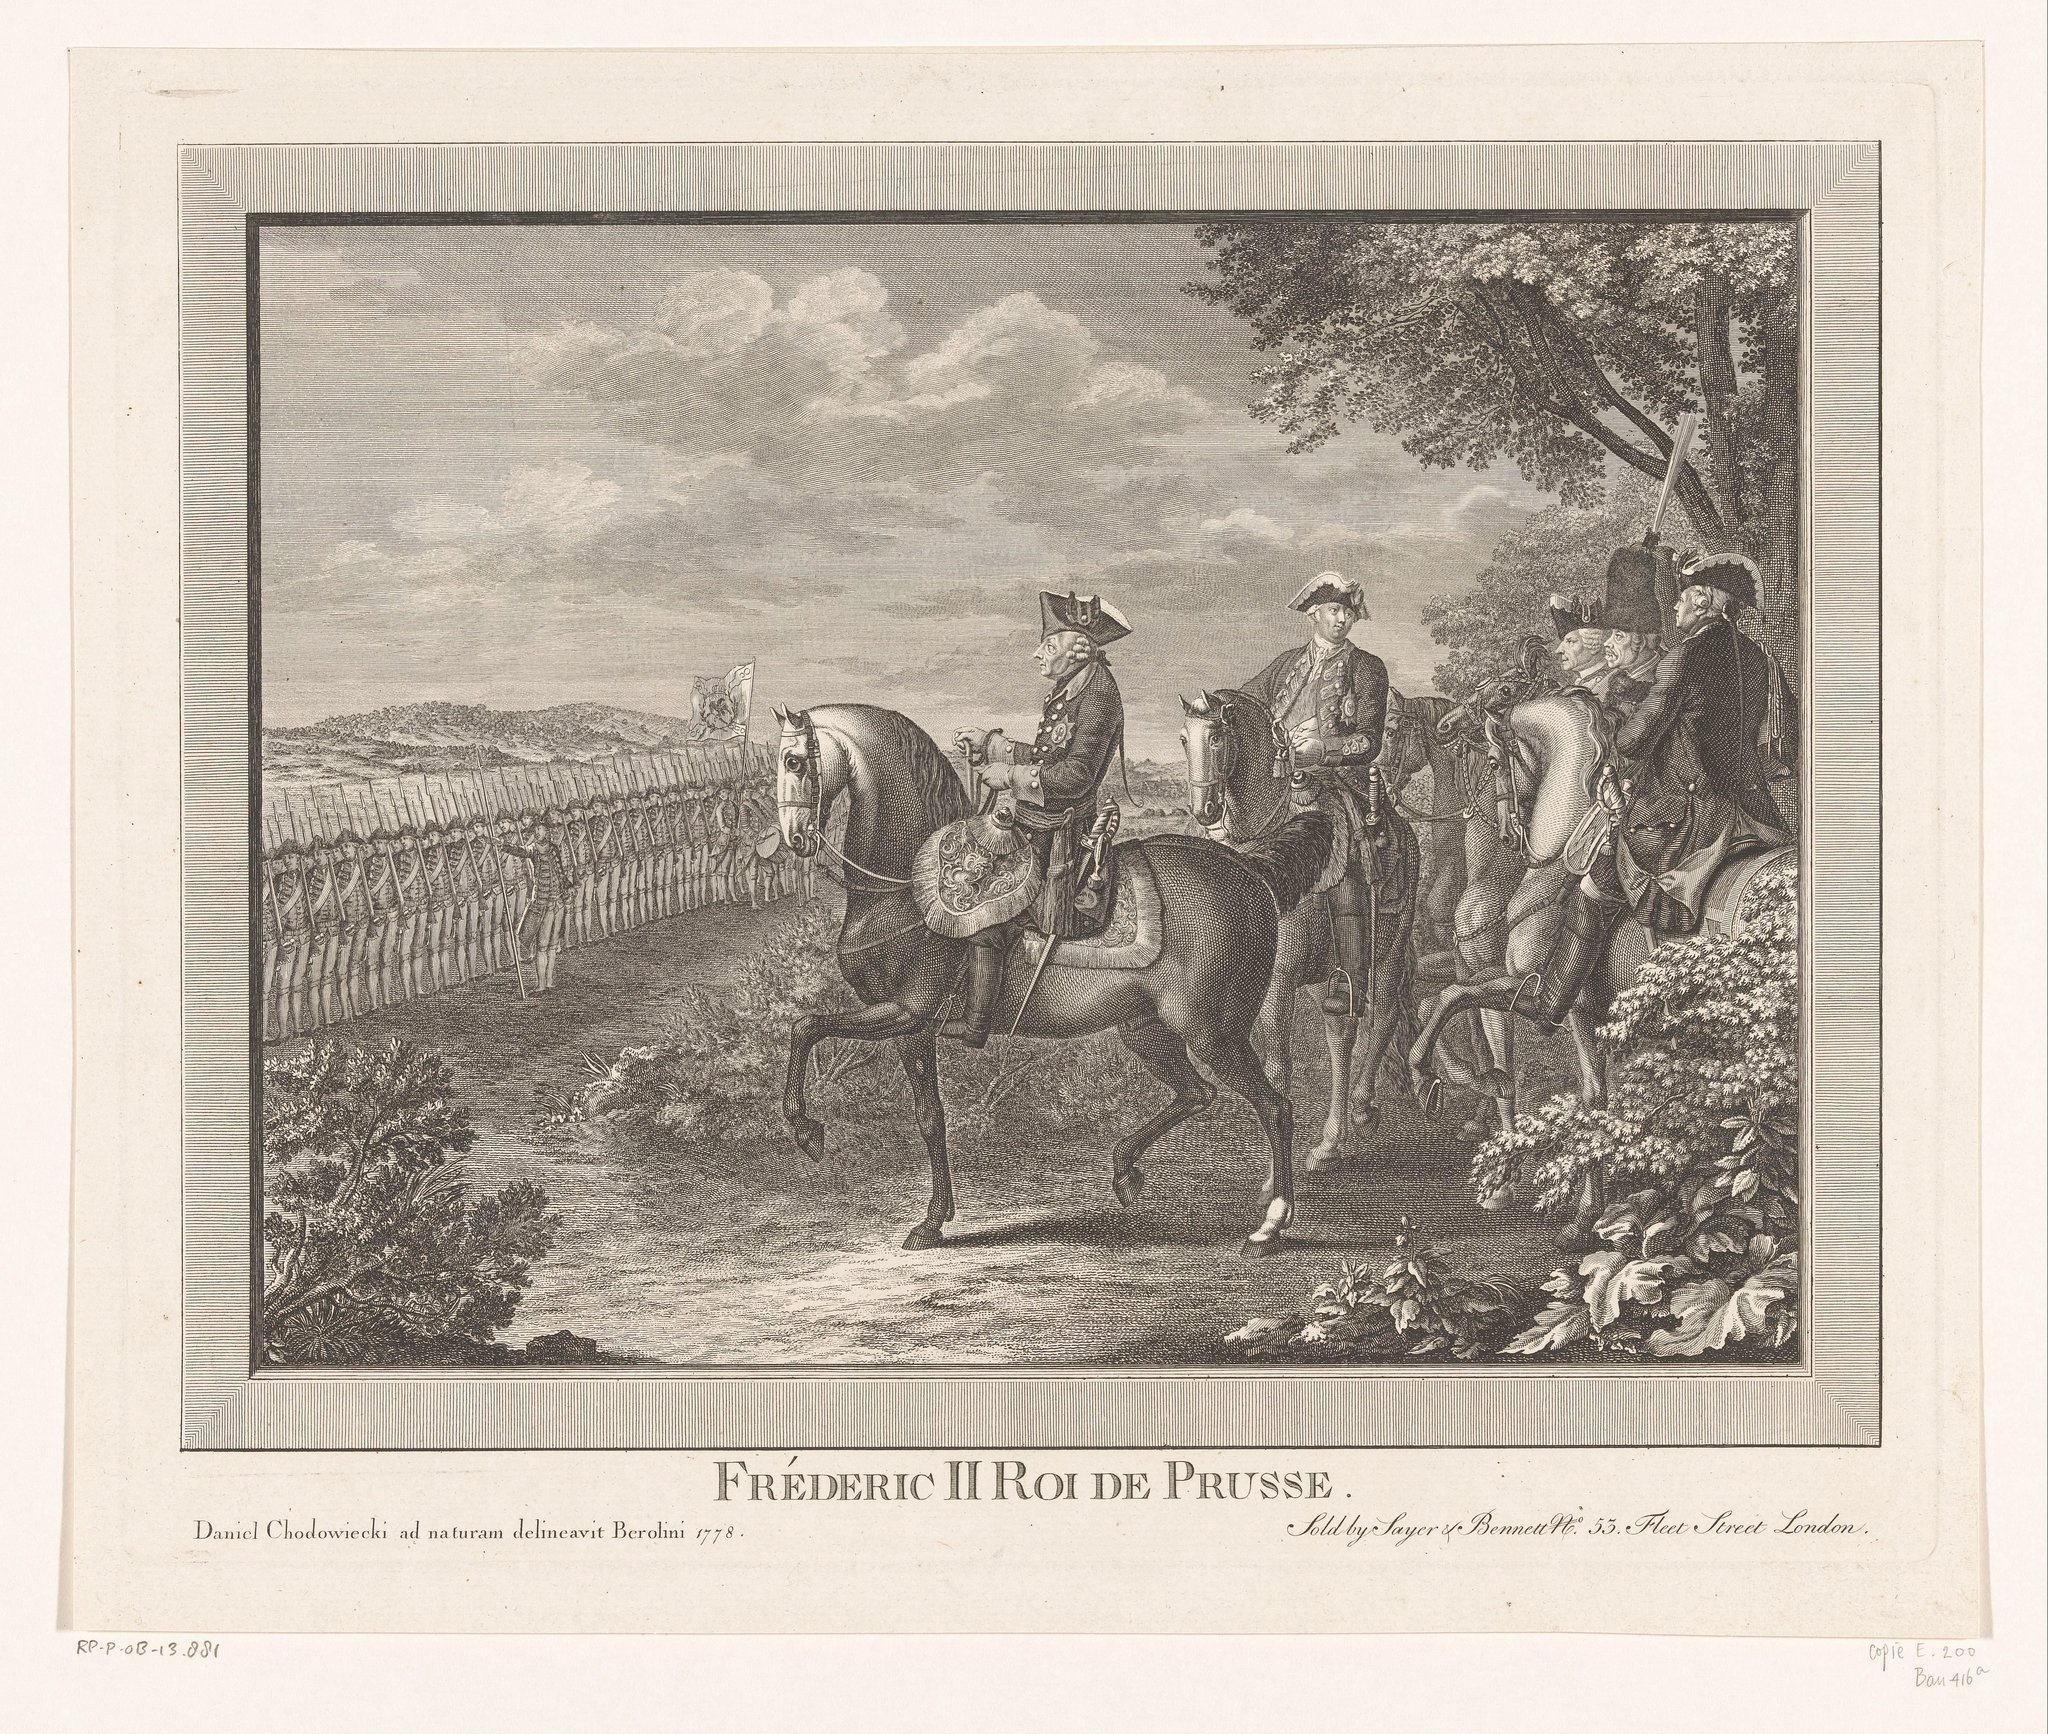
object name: print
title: Frederik de Grote inspecteert de troepen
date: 1778-1784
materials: paper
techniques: etching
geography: london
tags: berlin, frederik willem ii (koning van pruisen), frederick ii (king of prussia), equestrian state-portrait, review, inspection (of company, unit, troop), historical persons, banner, standard (as symbol of the state, etc.)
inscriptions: collector's mark: Lugt 2228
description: In het midden Frederik de Grote te paard. Schuin achter hem zijn neef, Frederik Willem II van Pruisen. Daar achter de generaals Friedrich Ehrenreich von Ramin en Hans Joachim von Zieten met een vleugeladjudant.